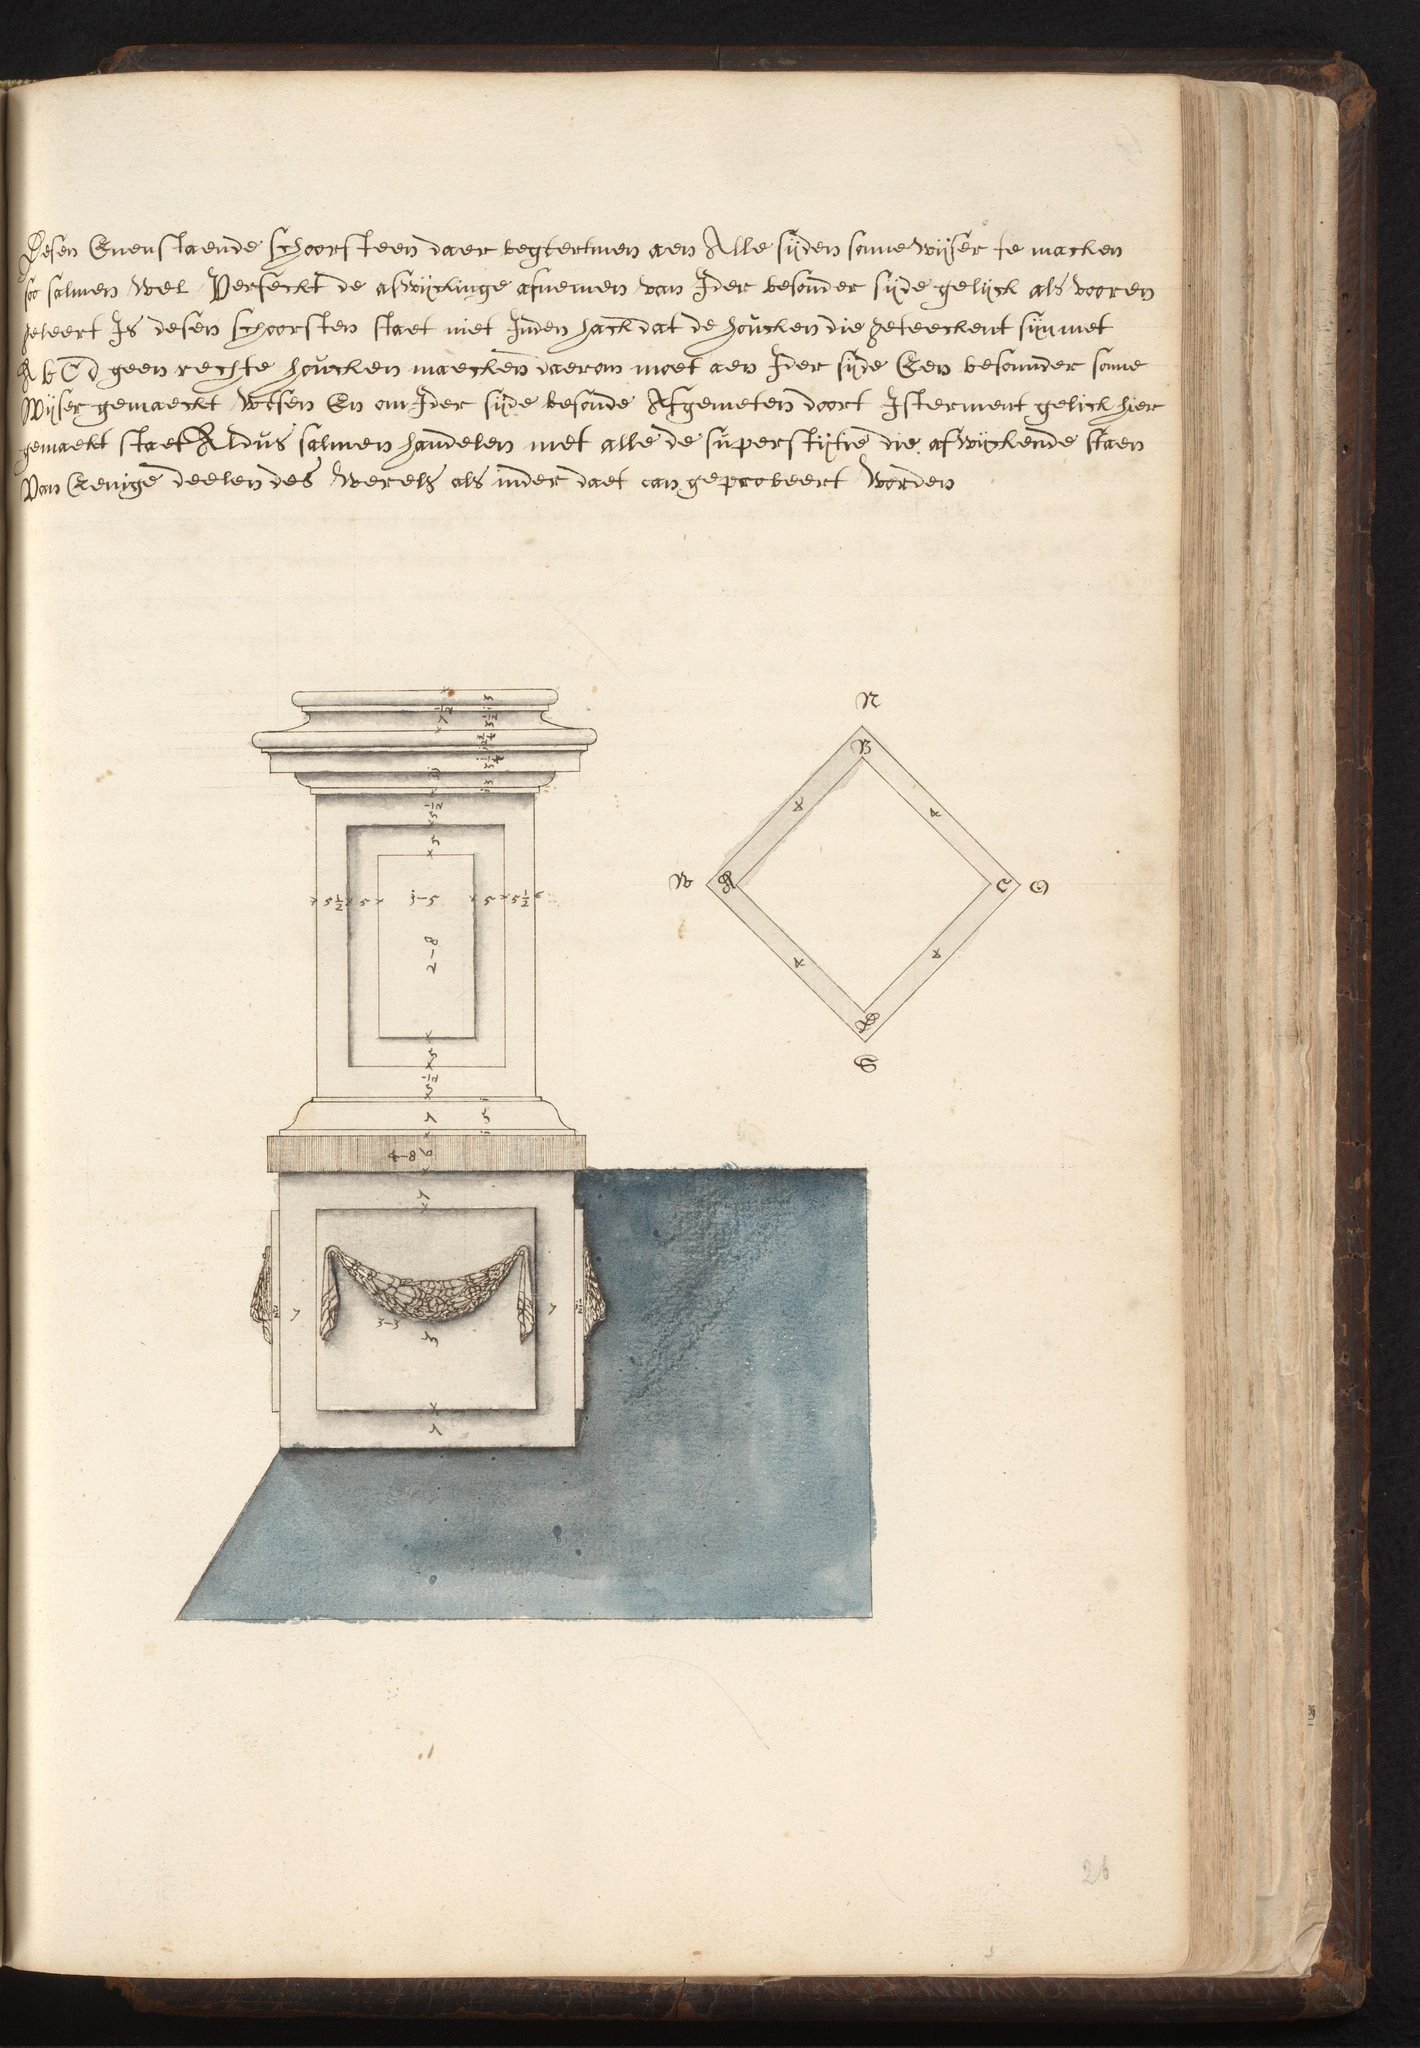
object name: drawing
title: Schoorsteen en bovenaanzicht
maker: Anonymous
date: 1650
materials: ink, paper, pencil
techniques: brush, pen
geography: low countries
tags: chimney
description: Met afmetingen. Tekening maakt deel uit van een album.